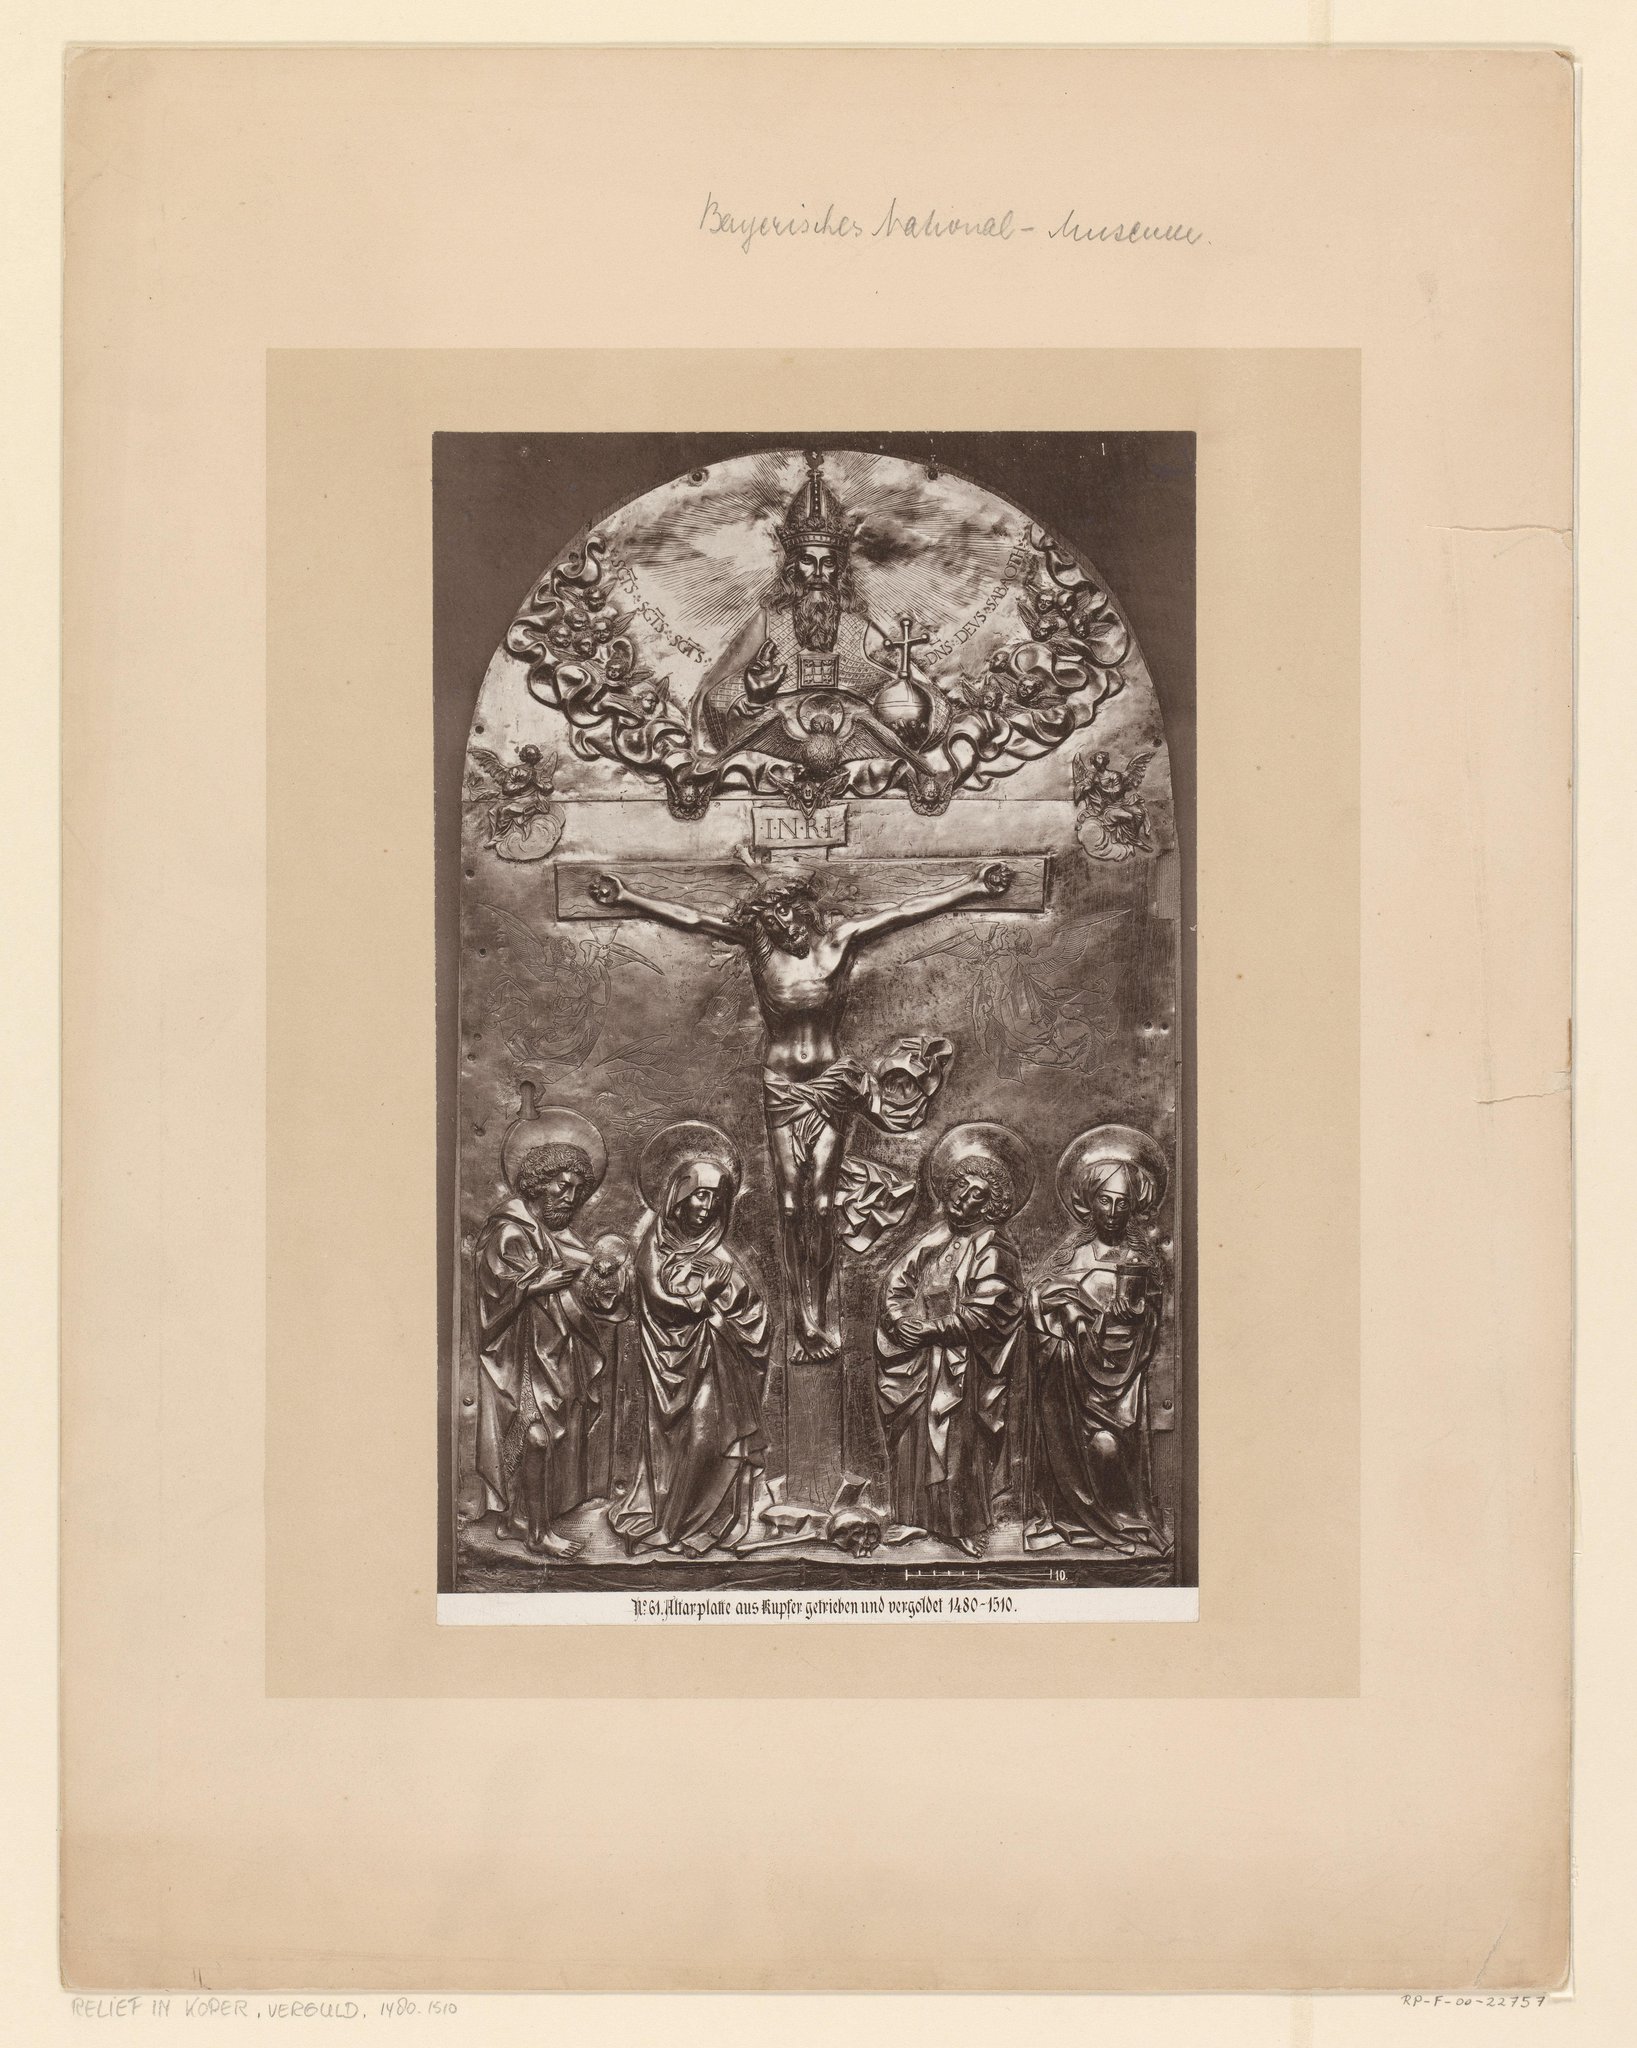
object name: photomechanical print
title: Reliëf met de kruisiging van Christus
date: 1869-1887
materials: cardboard, paper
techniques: photograph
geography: munich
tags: crucified christ, with particular persons under the cross, piece of sculpture, reproduction of a piece of sculpture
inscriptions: title: ‘No. 61. Altarplatte aus Kupfer getrieben und vergoldet 1480-1510’, check stamp: ‘Bayerisches National-Museum’, stamp: ‘ICON’, collector's mark: Lugt 3937, inscription: ‘Bayerisches National-Museum’